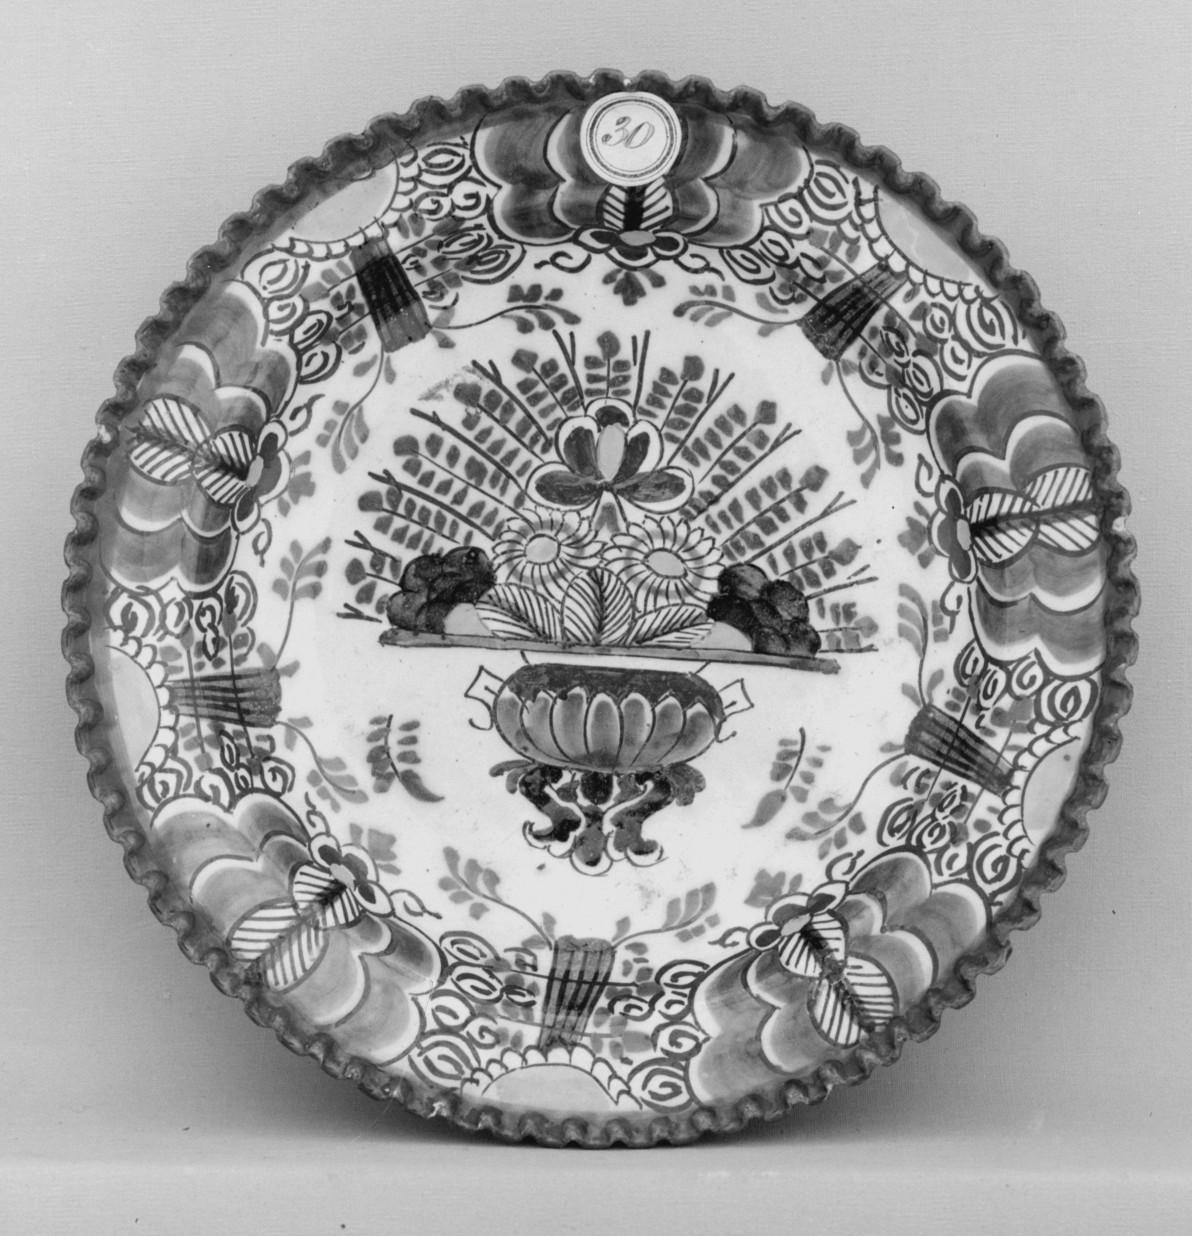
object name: plate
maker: de porceleyne lampetkan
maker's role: factory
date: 1767-1800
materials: earthenware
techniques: glazing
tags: flowers